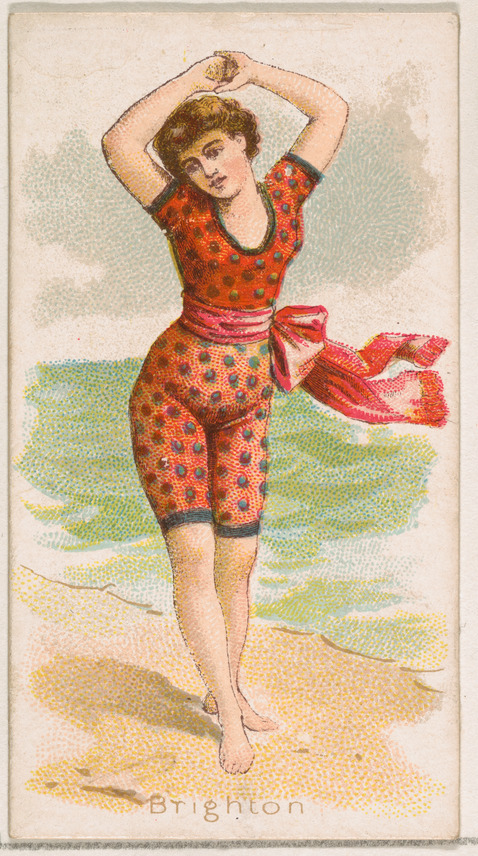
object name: print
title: Brighton, from the Fancy Bathers series (N187) issued by Wm. S. Kimball & Co.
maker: william s. kimball & company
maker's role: publisher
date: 1889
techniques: color lithograph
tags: women